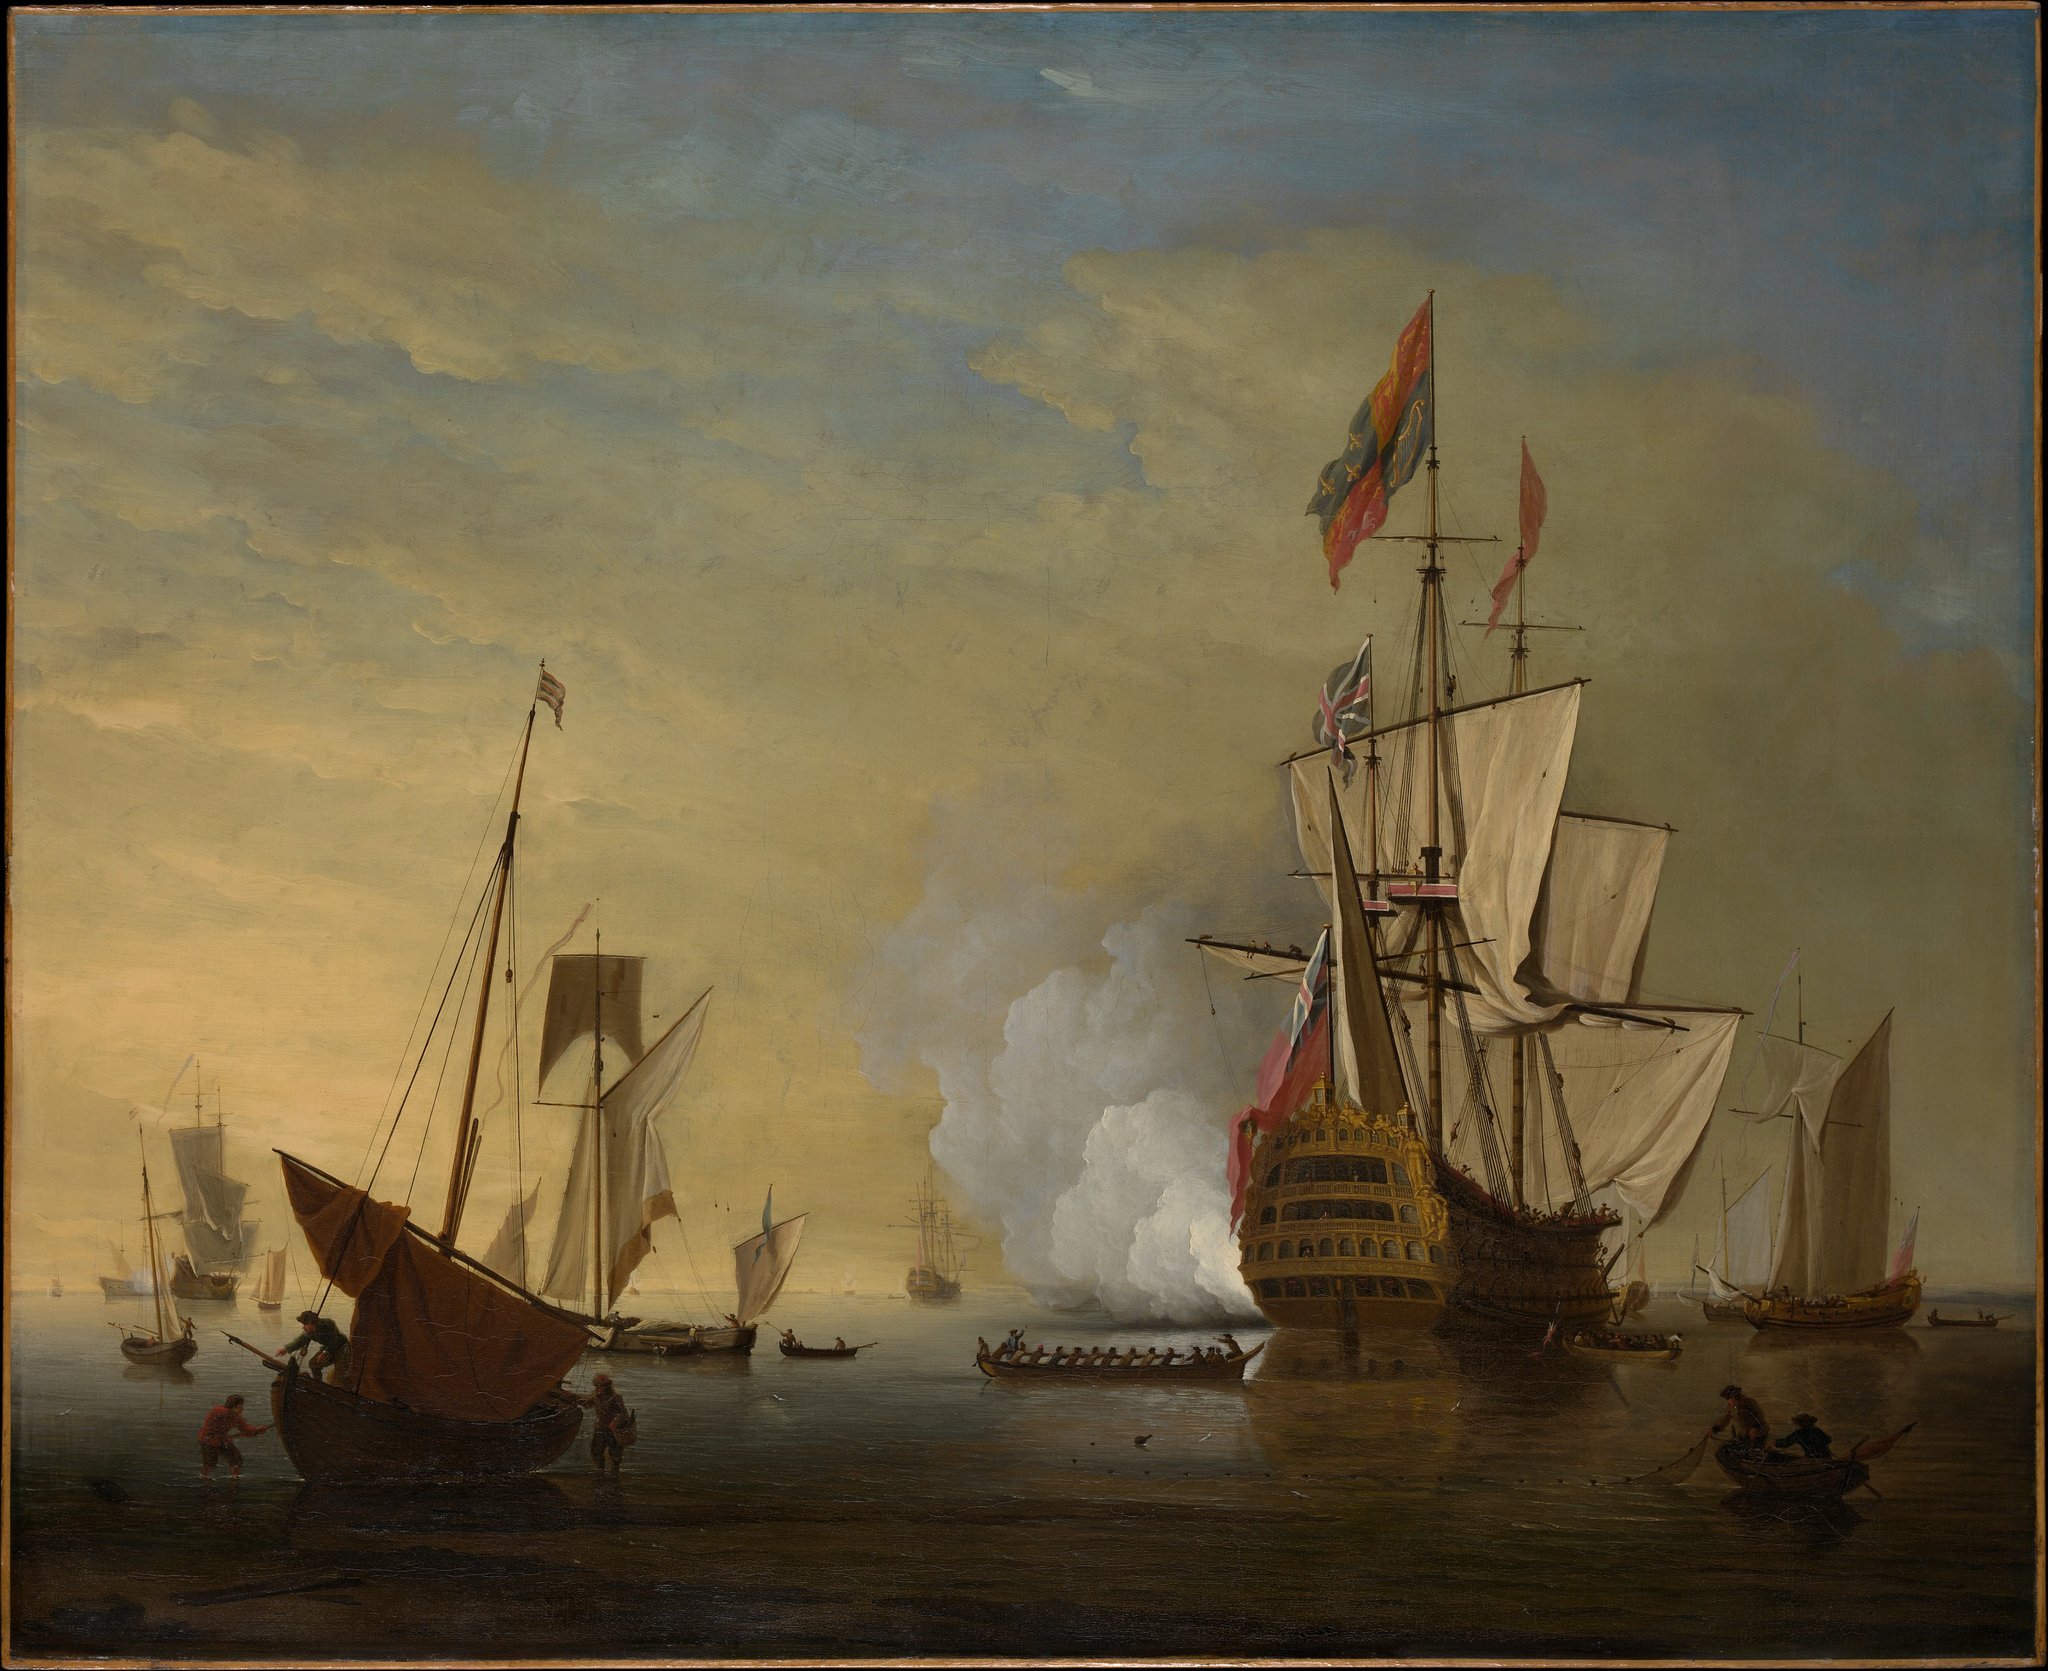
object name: painting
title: Harbor Scene: An English Ship with Sails Loosened Firing a Gun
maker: peter monamy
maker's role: artist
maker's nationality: british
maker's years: 1681-1749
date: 1704-1749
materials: canvas, oil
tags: ships,harbors